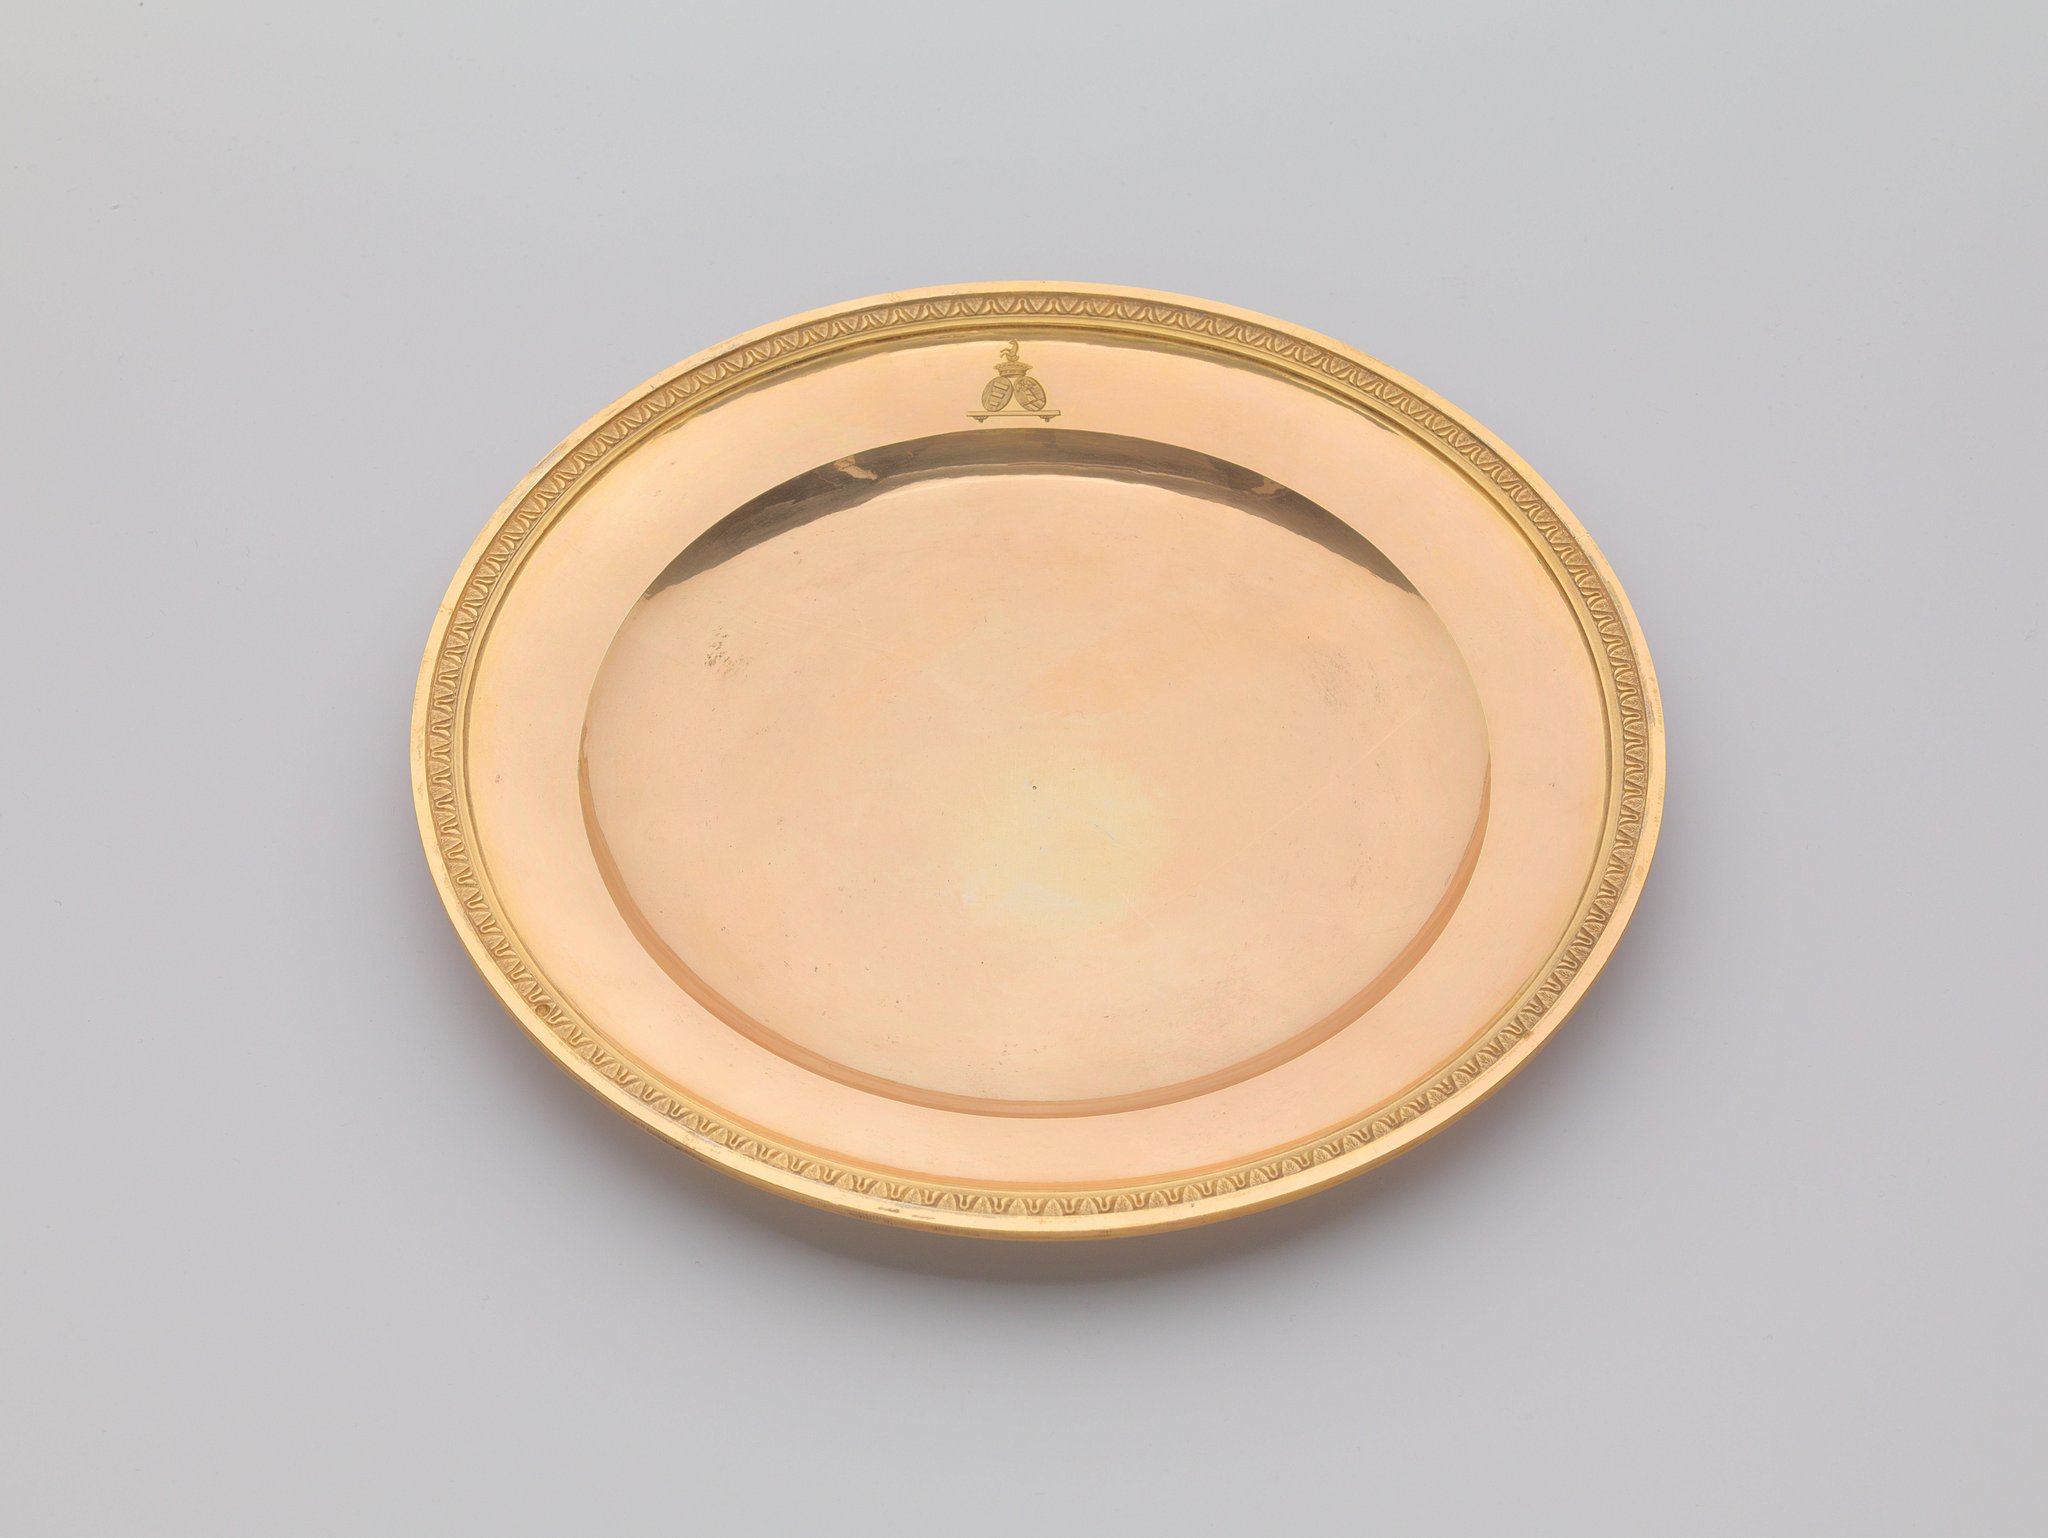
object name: plate dish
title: Bord van verguld zilver, met palmetrand. Op het plat het gegraveerde wapen Potemkin.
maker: Anonymous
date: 1809-1819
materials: silver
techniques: gilding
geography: paris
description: Empire bord van verguld zilver. Omgeven door een palmetrand. In het plat het gegraveerde wapen van Potemkin.